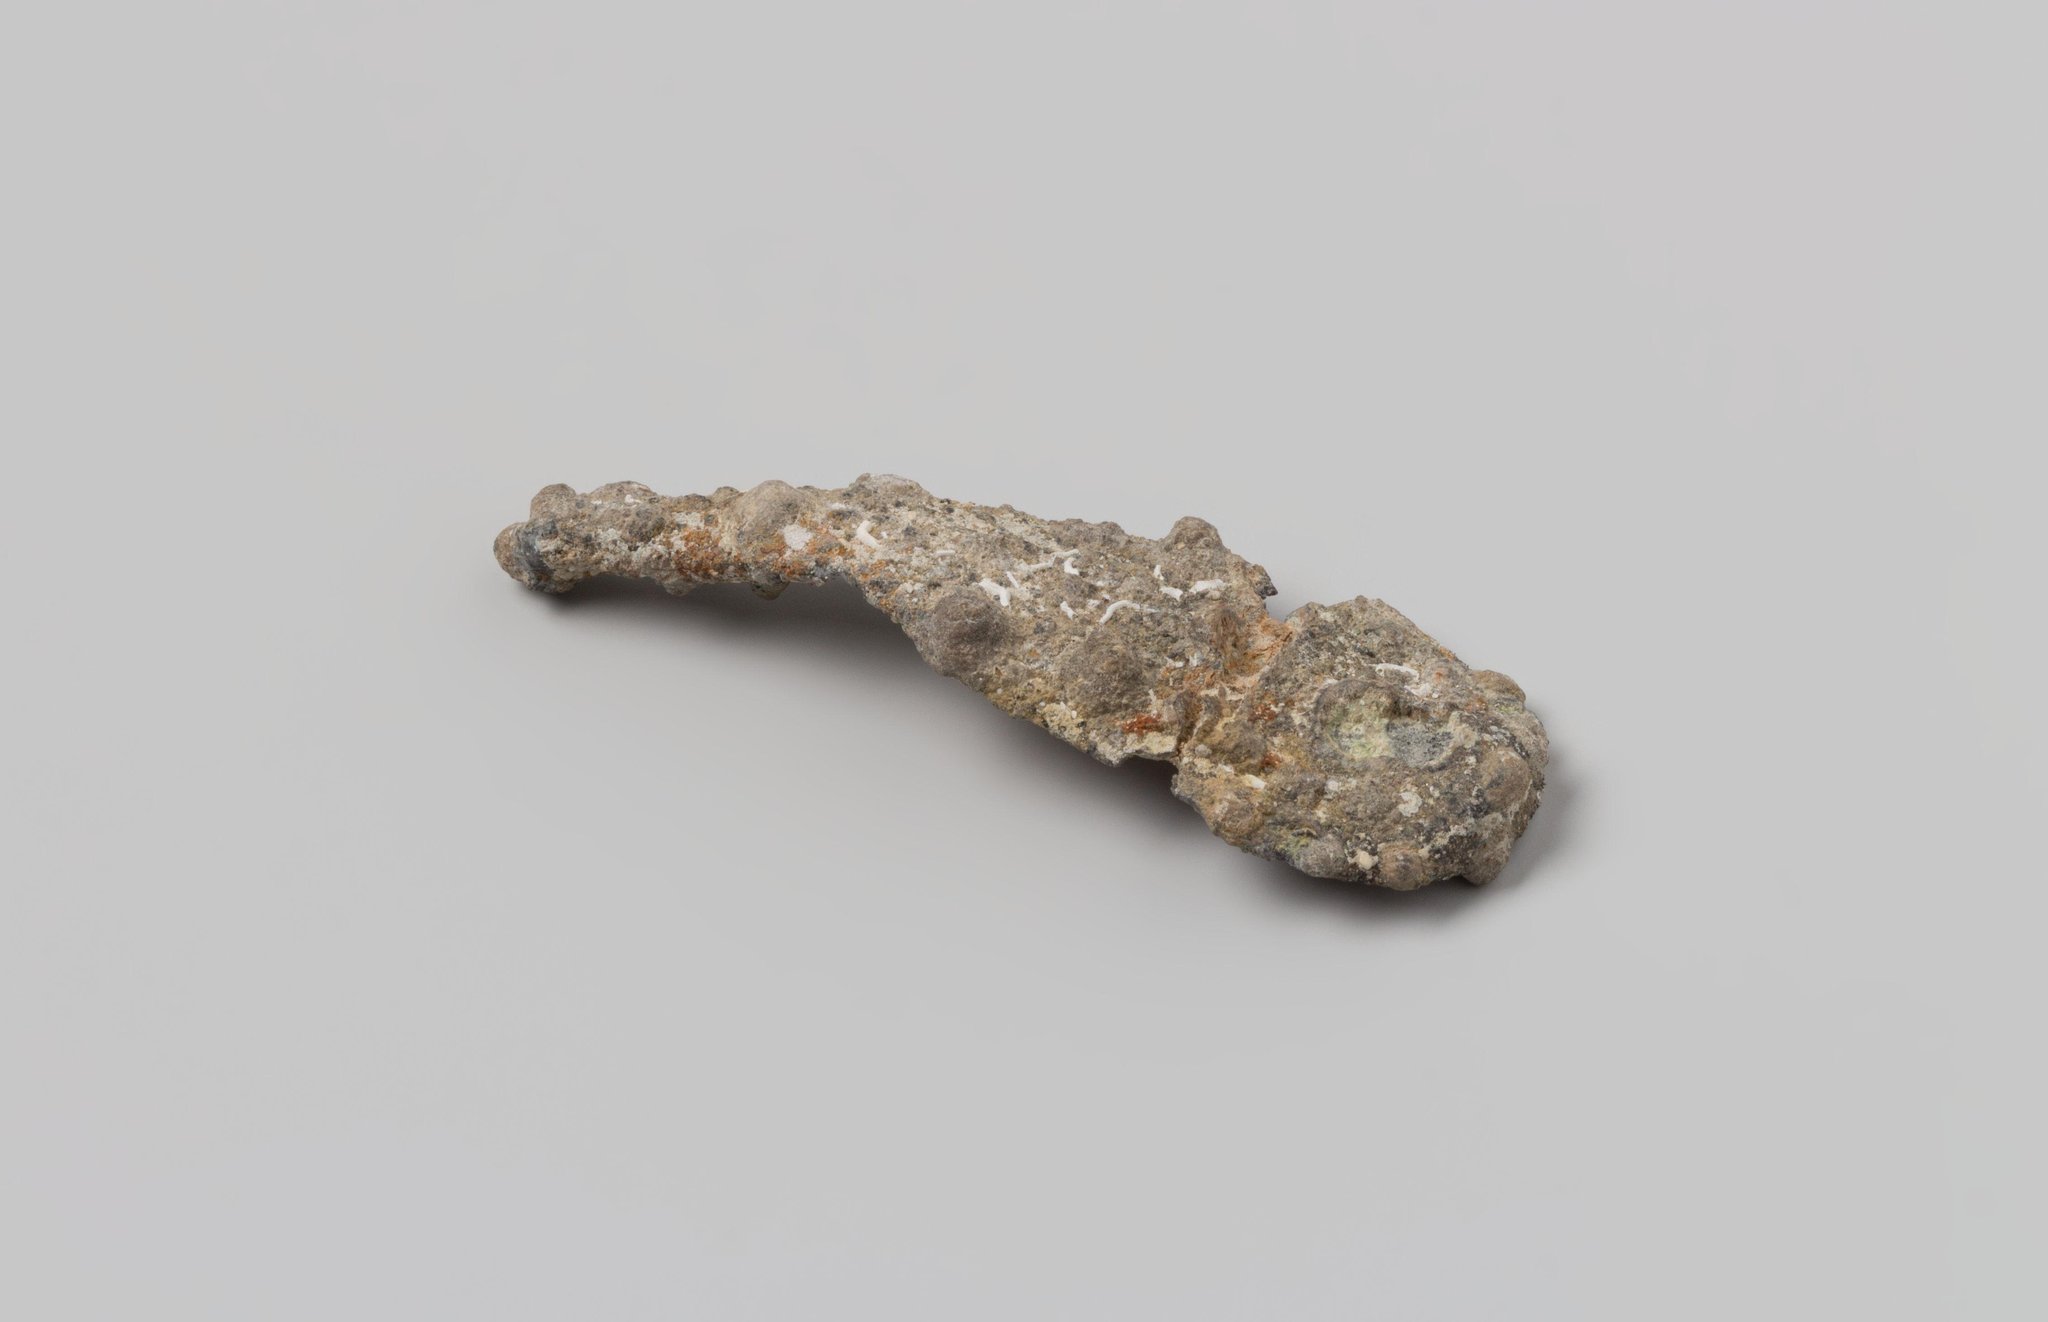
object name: spoon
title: Fragment steel van vork of lepel uit het wrak van de Oost-Indiëvaarder Hollandia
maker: Anonymous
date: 1700-1743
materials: tin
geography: netherlands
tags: verenigde oostindische compagnie, hollandia (schip), annet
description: Cutlery, fragment: stem of fork or spoon; fragm, corroded, id. NG 1980-27H67.